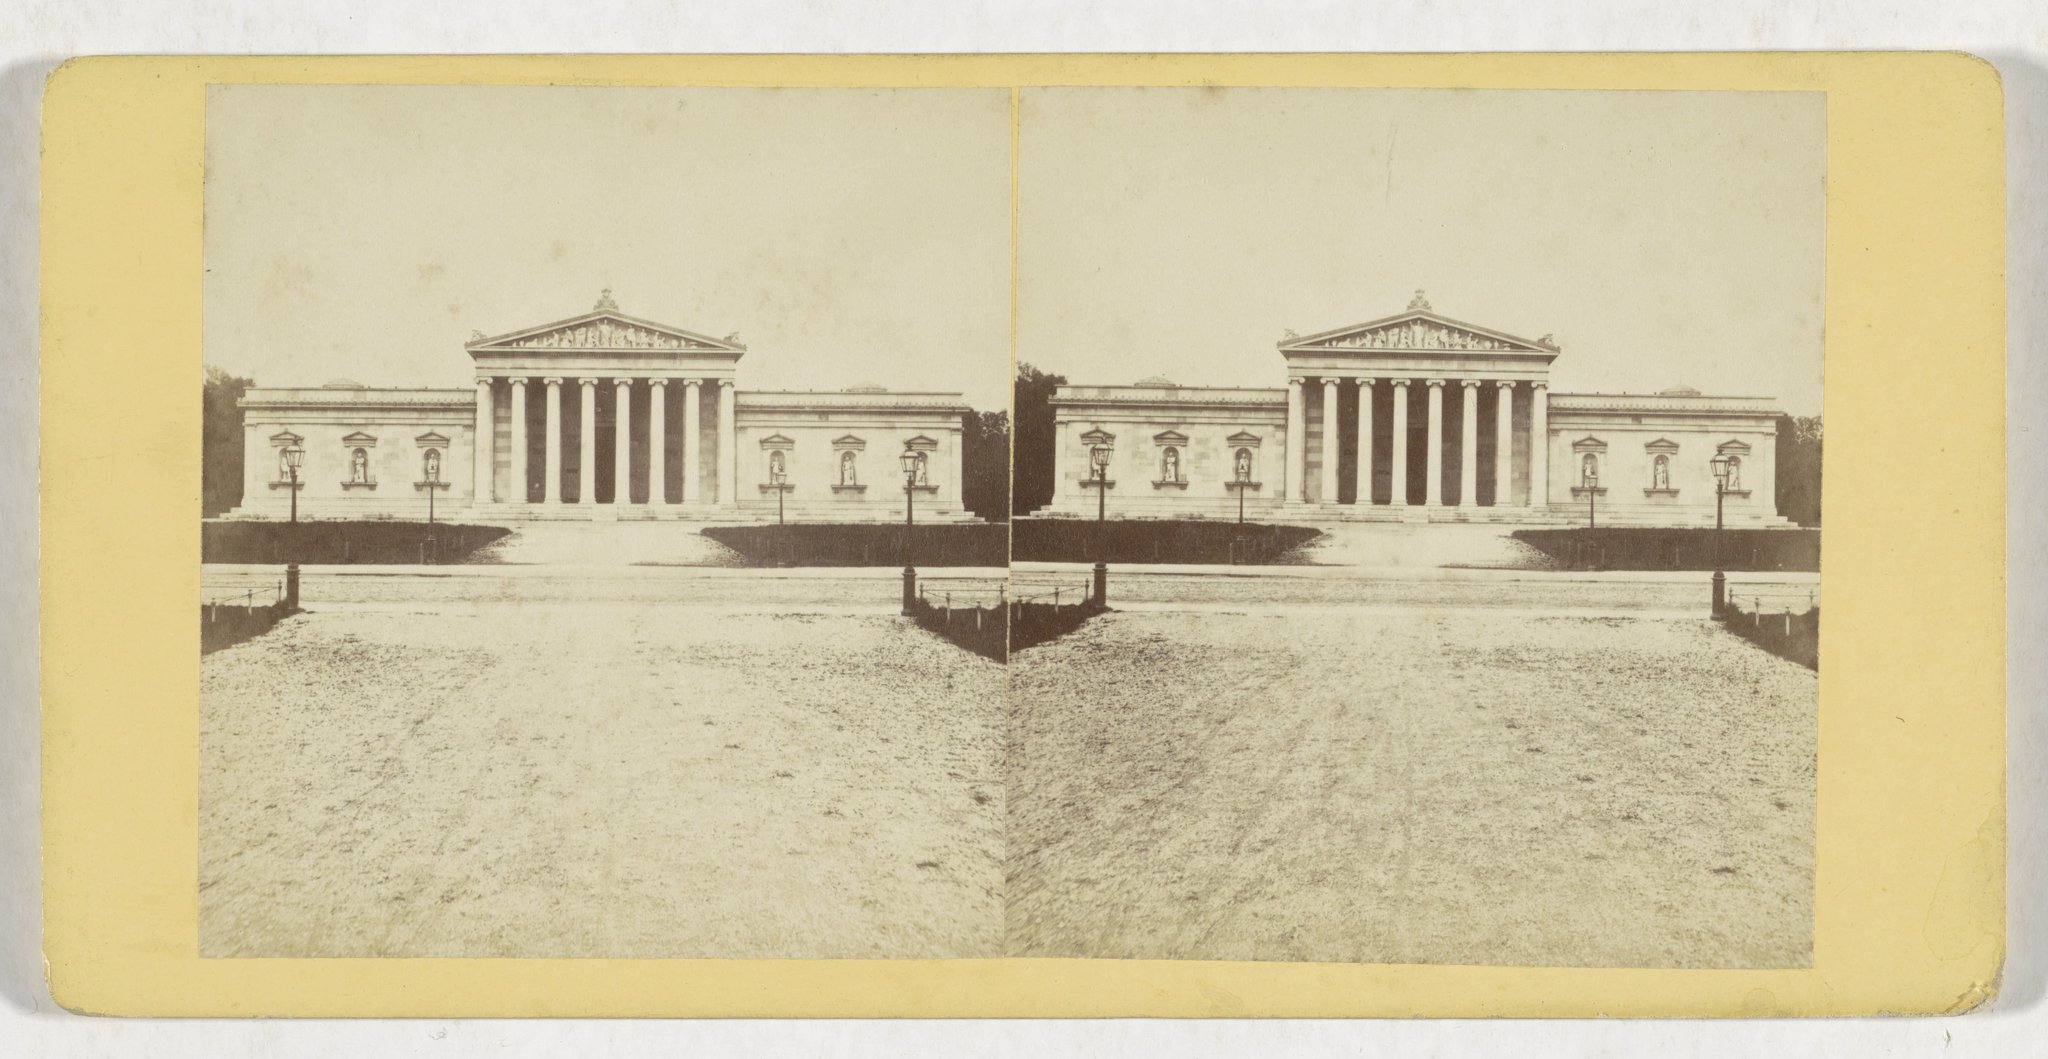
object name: stereograph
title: München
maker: johann friedrich stiehm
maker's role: fotograaf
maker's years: 1826-1902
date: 1868-1890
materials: cardboard, paper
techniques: albumen print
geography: munich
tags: permanent exhibition, museum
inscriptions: number: ‘No. 8.’